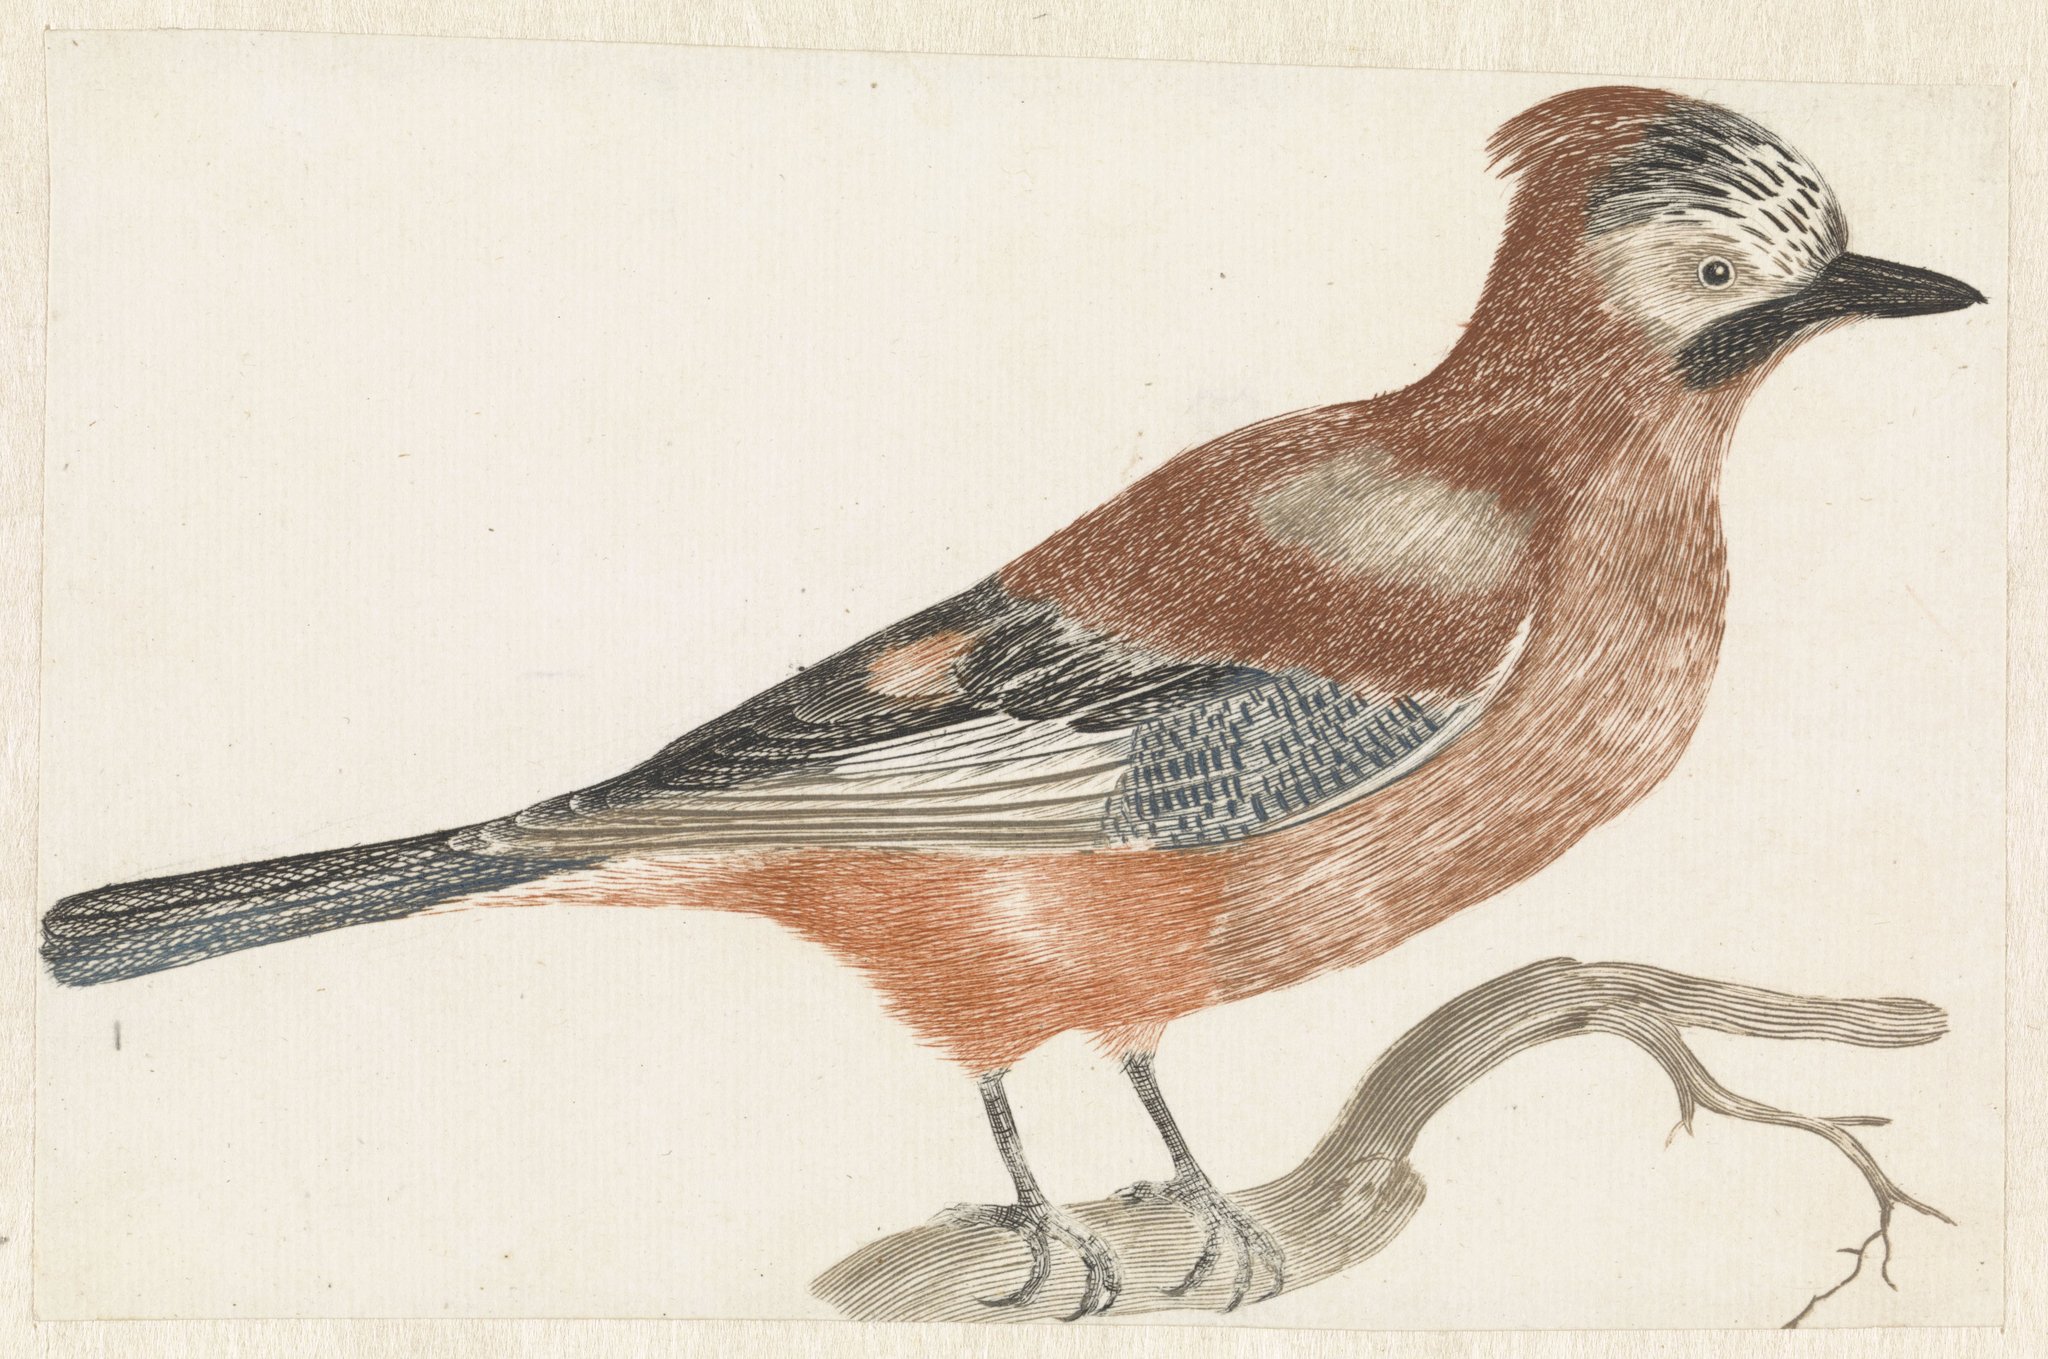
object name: print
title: Vlaamse gaai op een tak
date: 1688-1698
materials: paper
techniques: engraving, lithography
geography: netherlands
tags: birds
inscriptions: collector's mark: Lugt 2228, collector's mark: Lugt 2760